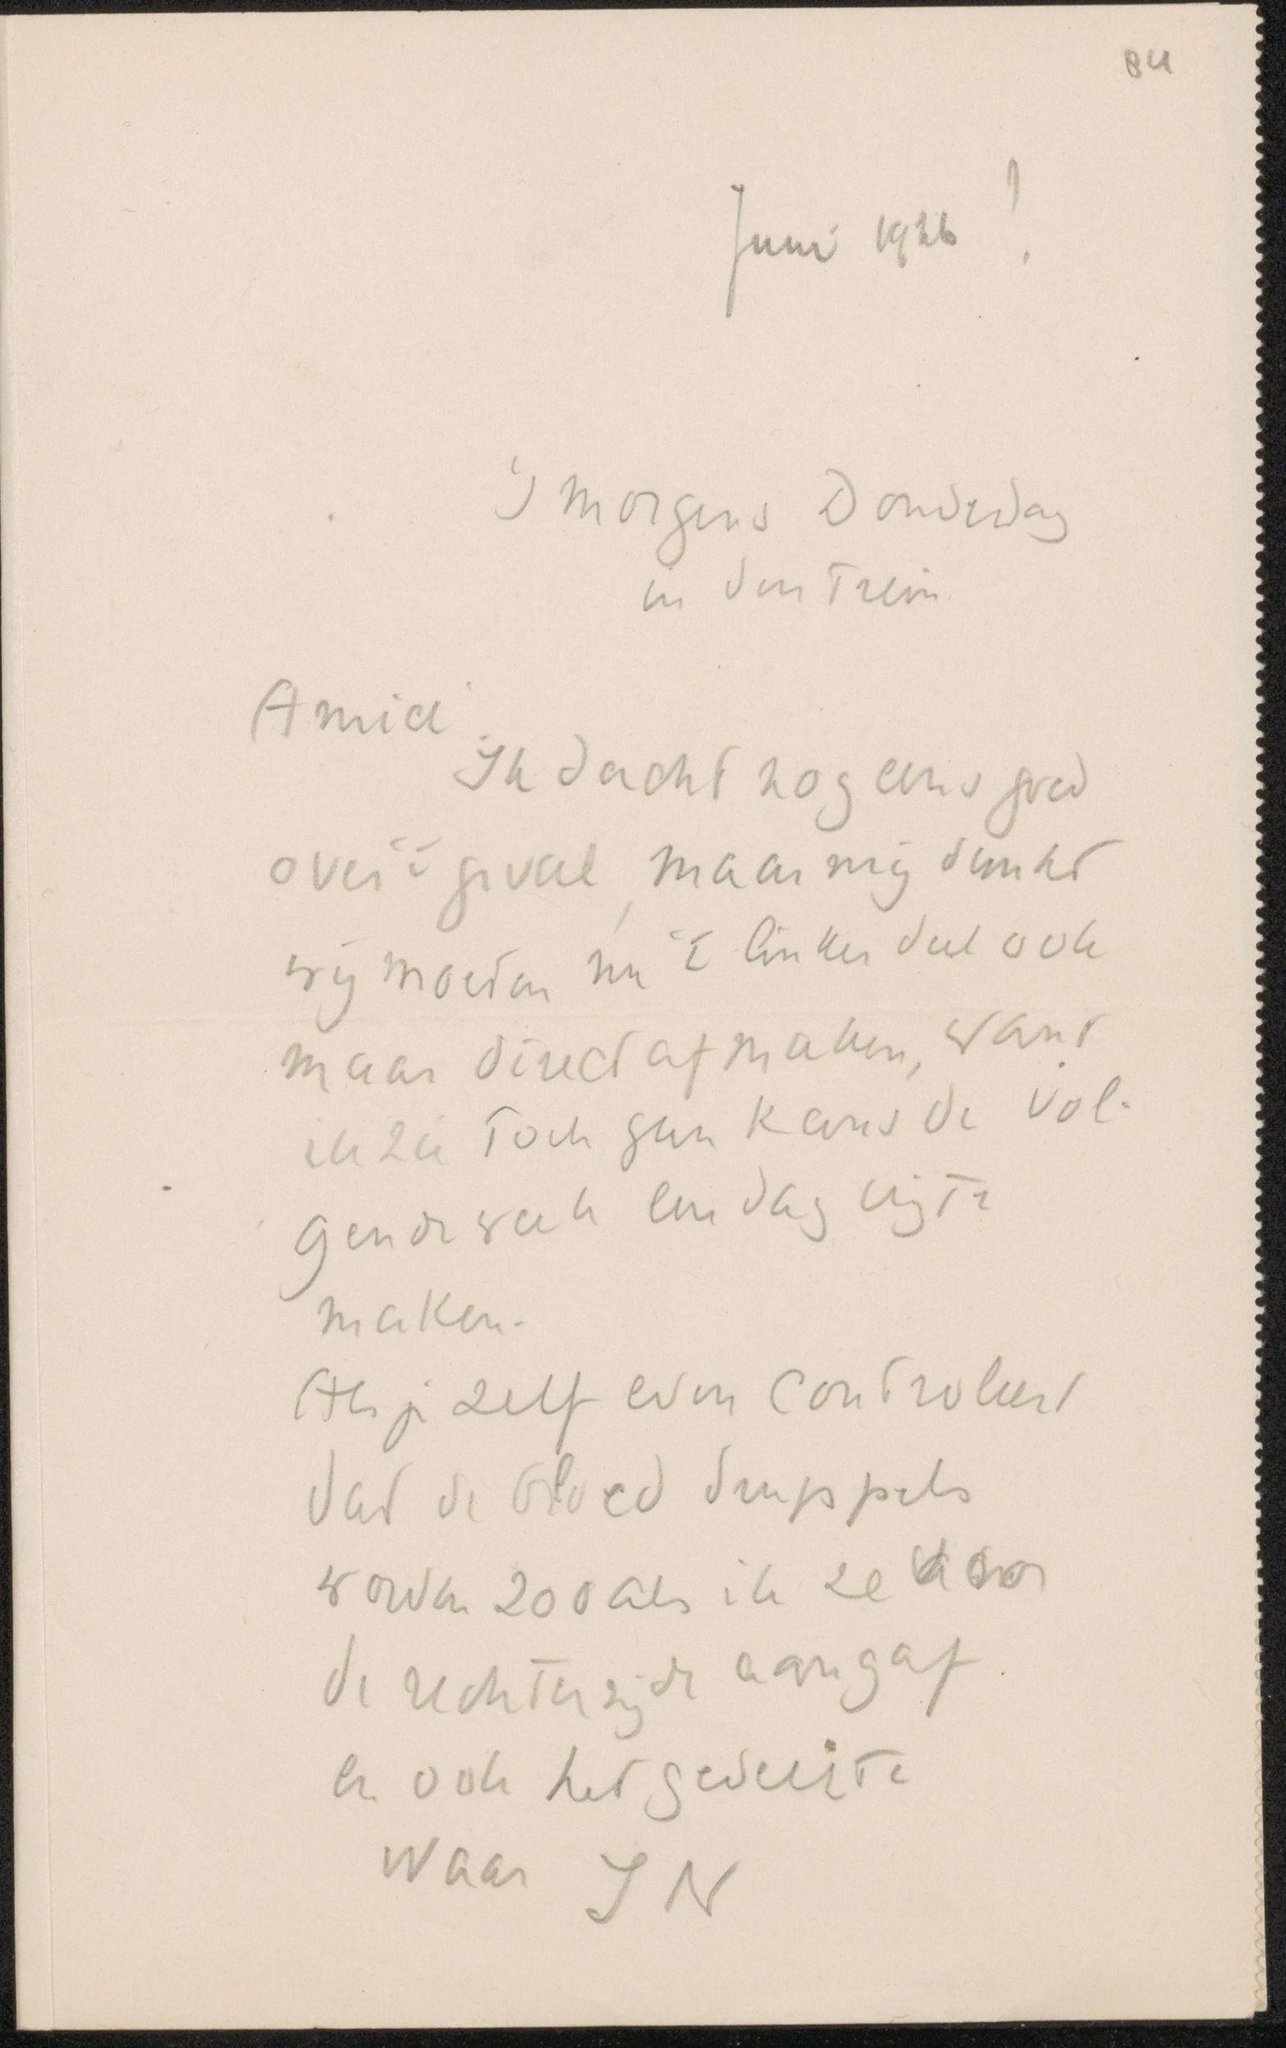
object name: letter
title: Brief aan Willem Bogtman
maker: richard nicolaüs roland holst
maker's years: 1868-1938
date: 1926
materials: paper, pencil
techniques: pen, writing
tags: willem bogtman, applied arts, arts and crafts; industrial design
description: Brief gedateerd Juni 1926? in latere hand.